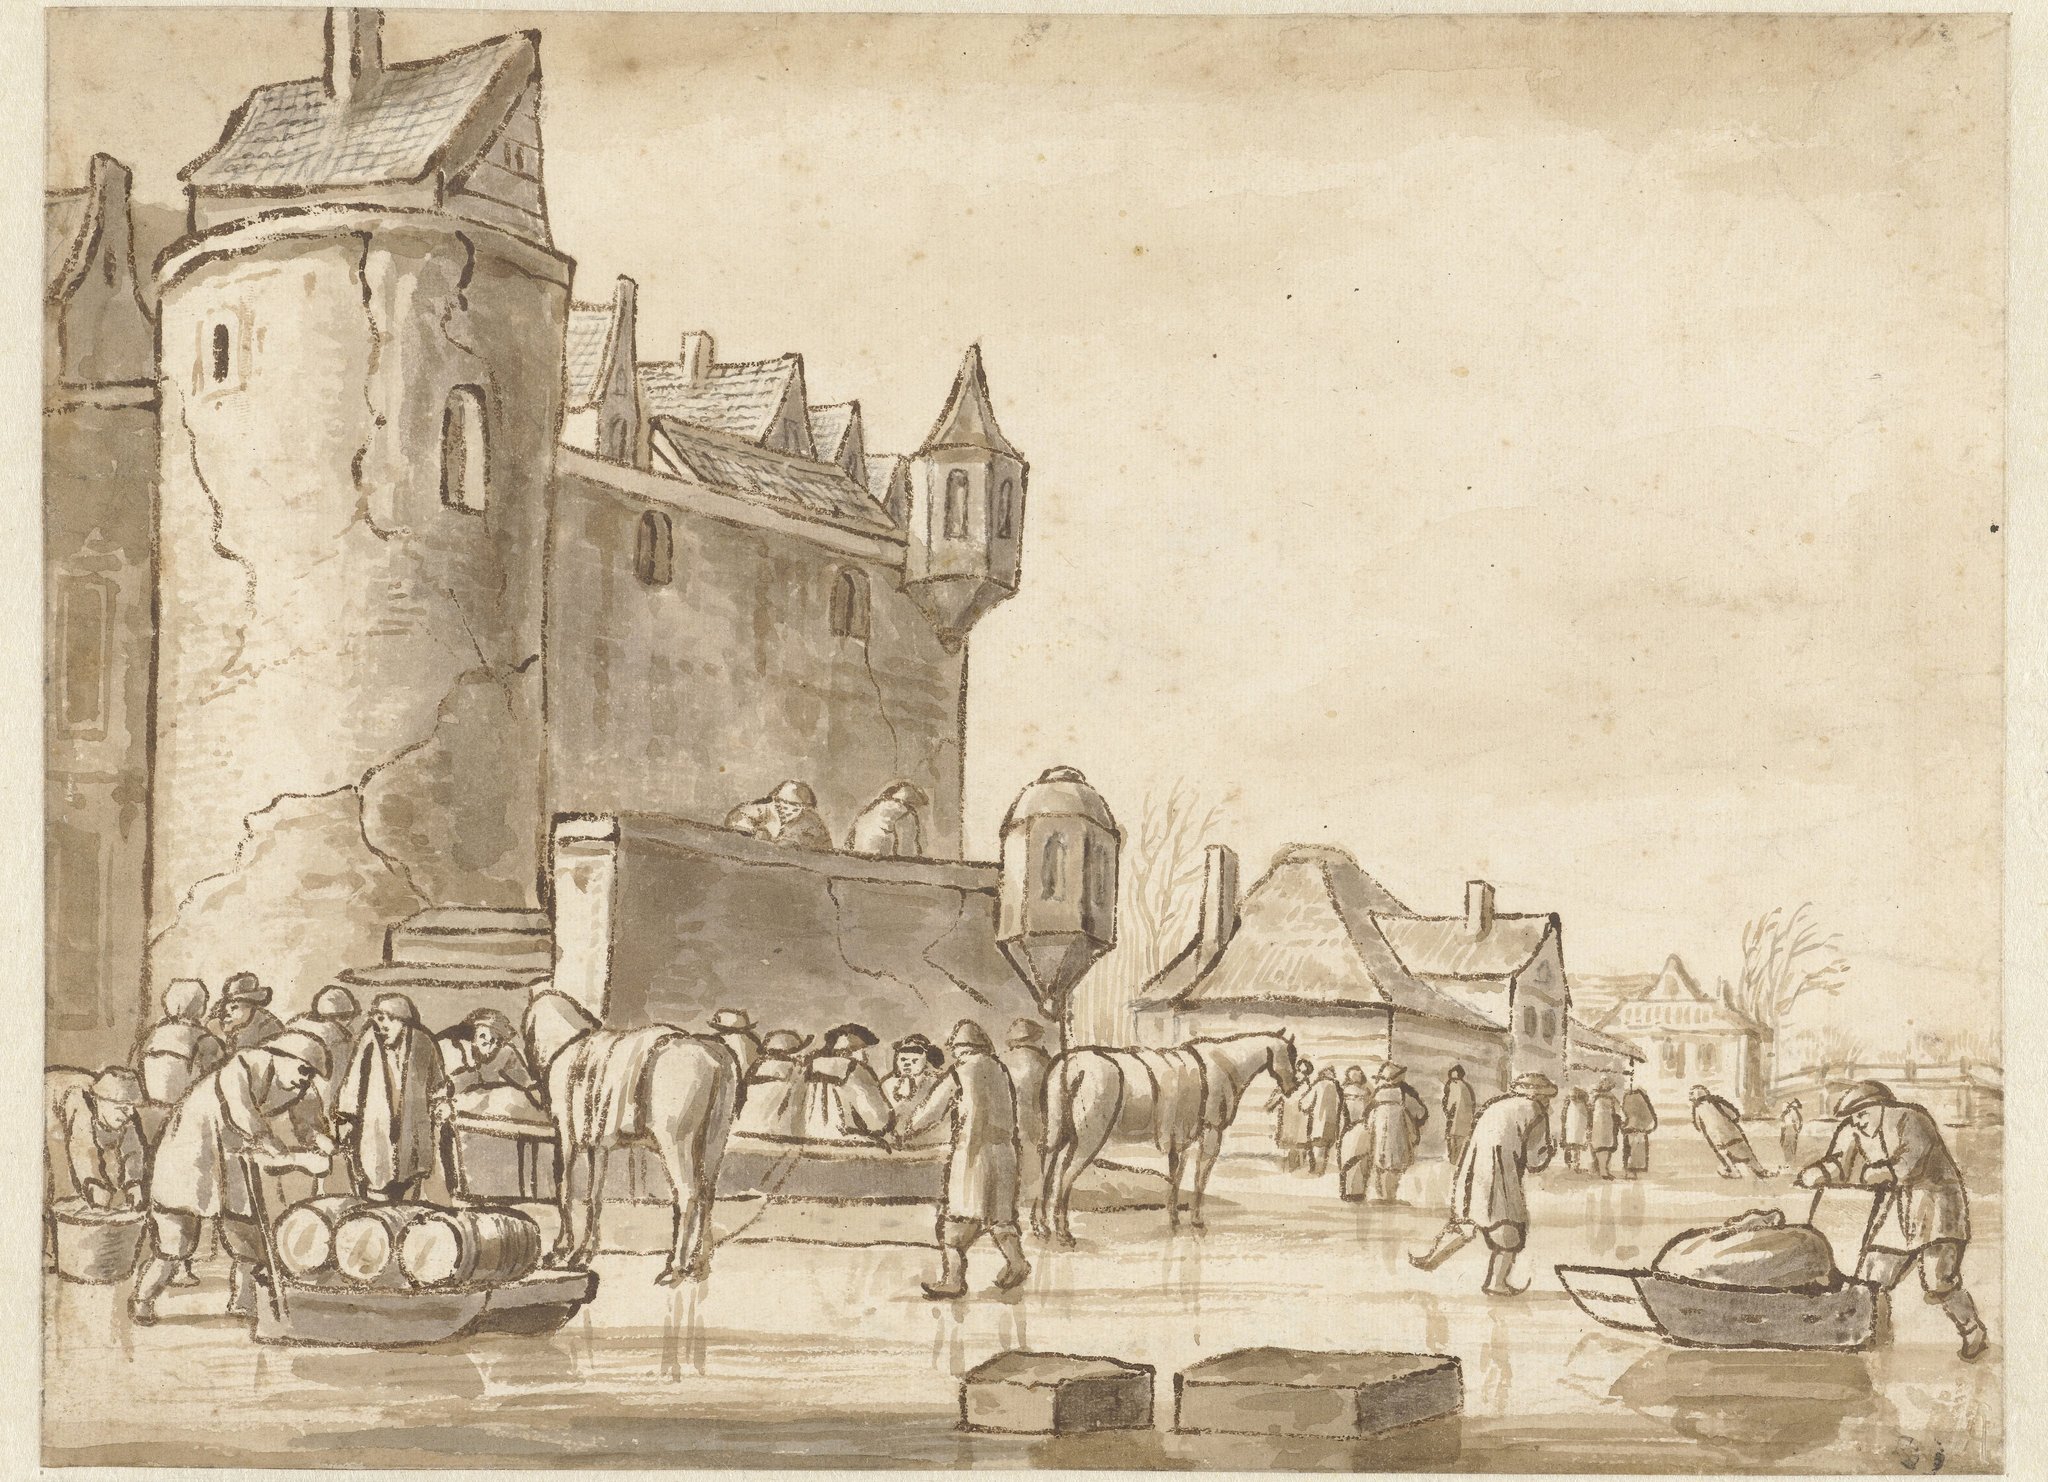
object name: drawing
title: Schaatsenrijders en sleden voor een stadswal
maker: nicolaes molenaer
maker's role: draughtsman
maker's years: 1630-1676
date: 1640-1676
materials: ink, oil, paper, pencil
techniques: brush, printmaking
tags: winter sports, city-walls